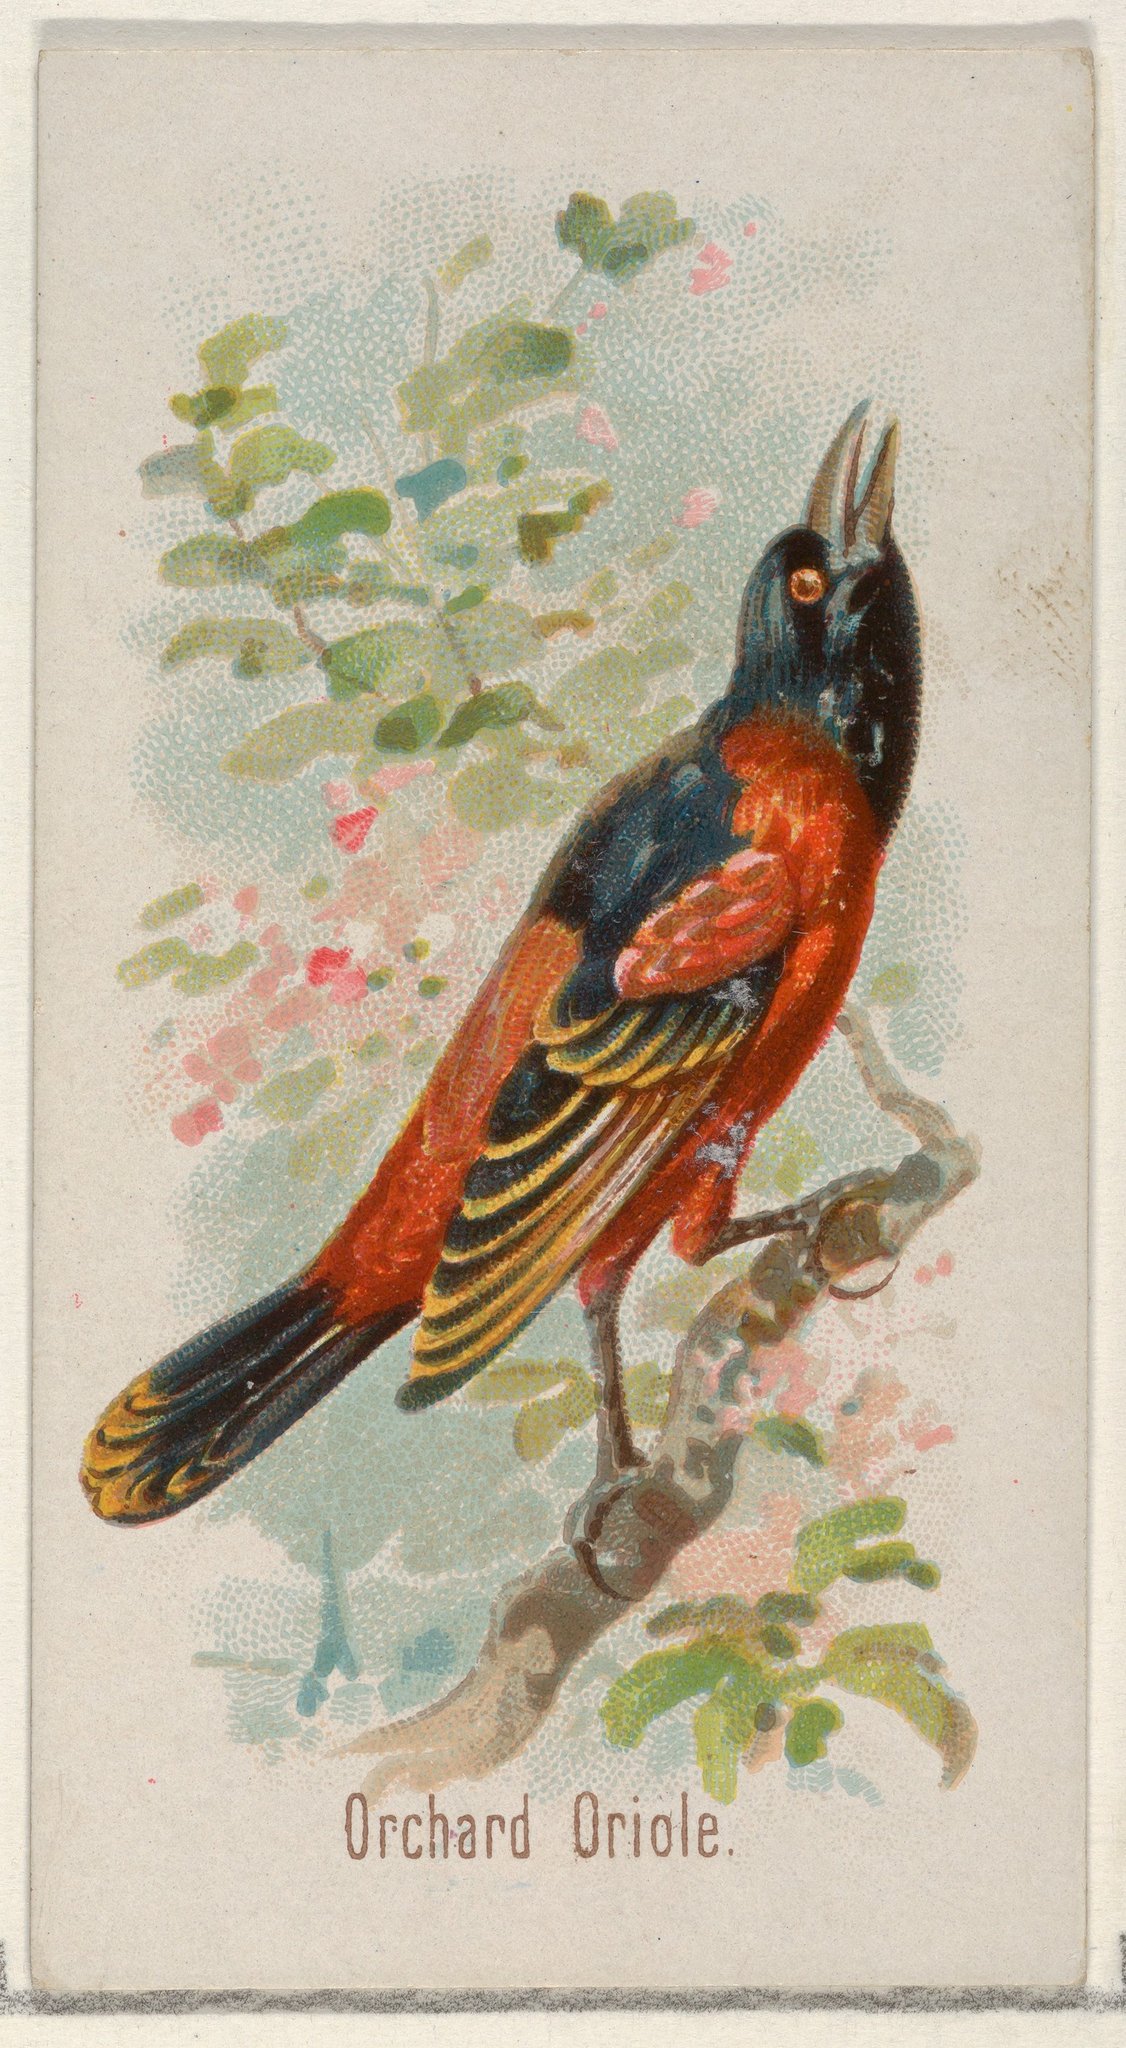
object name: print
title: Orchard Oriole, from the Song Birds of the World series (N23) for Allen & Ginter Cigarettes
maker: allen & ginter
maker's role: publisher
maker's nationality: american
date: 1890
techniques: color lithograph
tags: birds